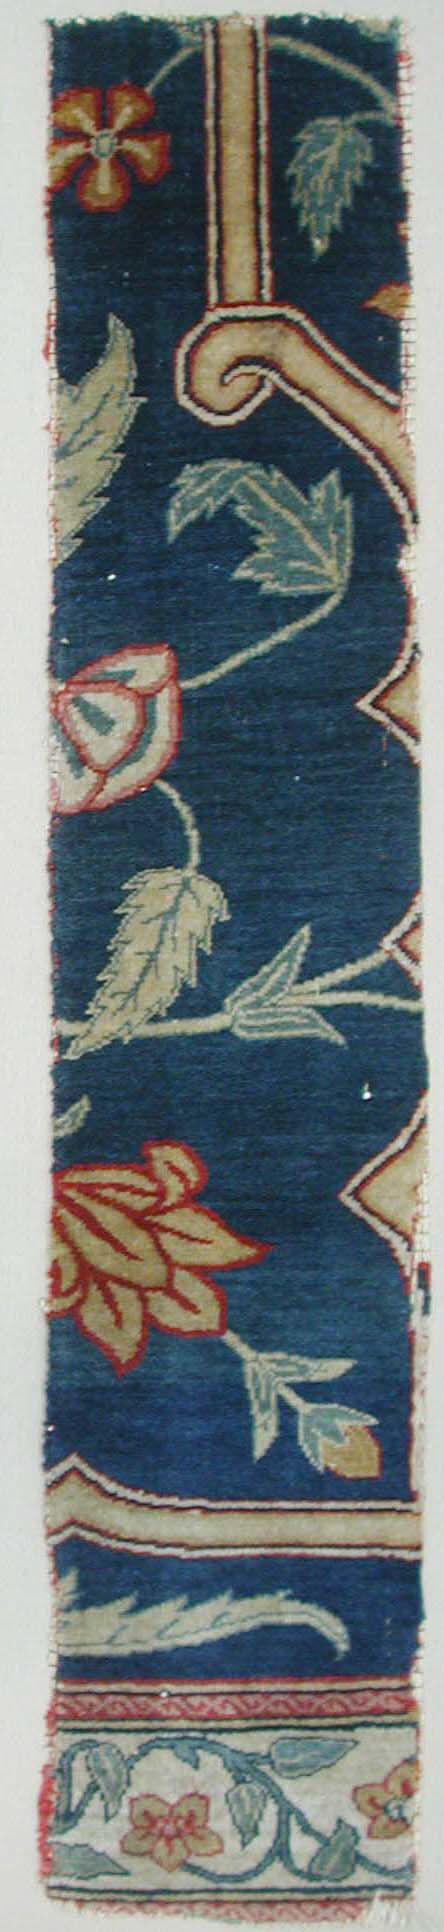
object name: textile fragment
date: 1651-1675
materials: silk, wool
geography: india